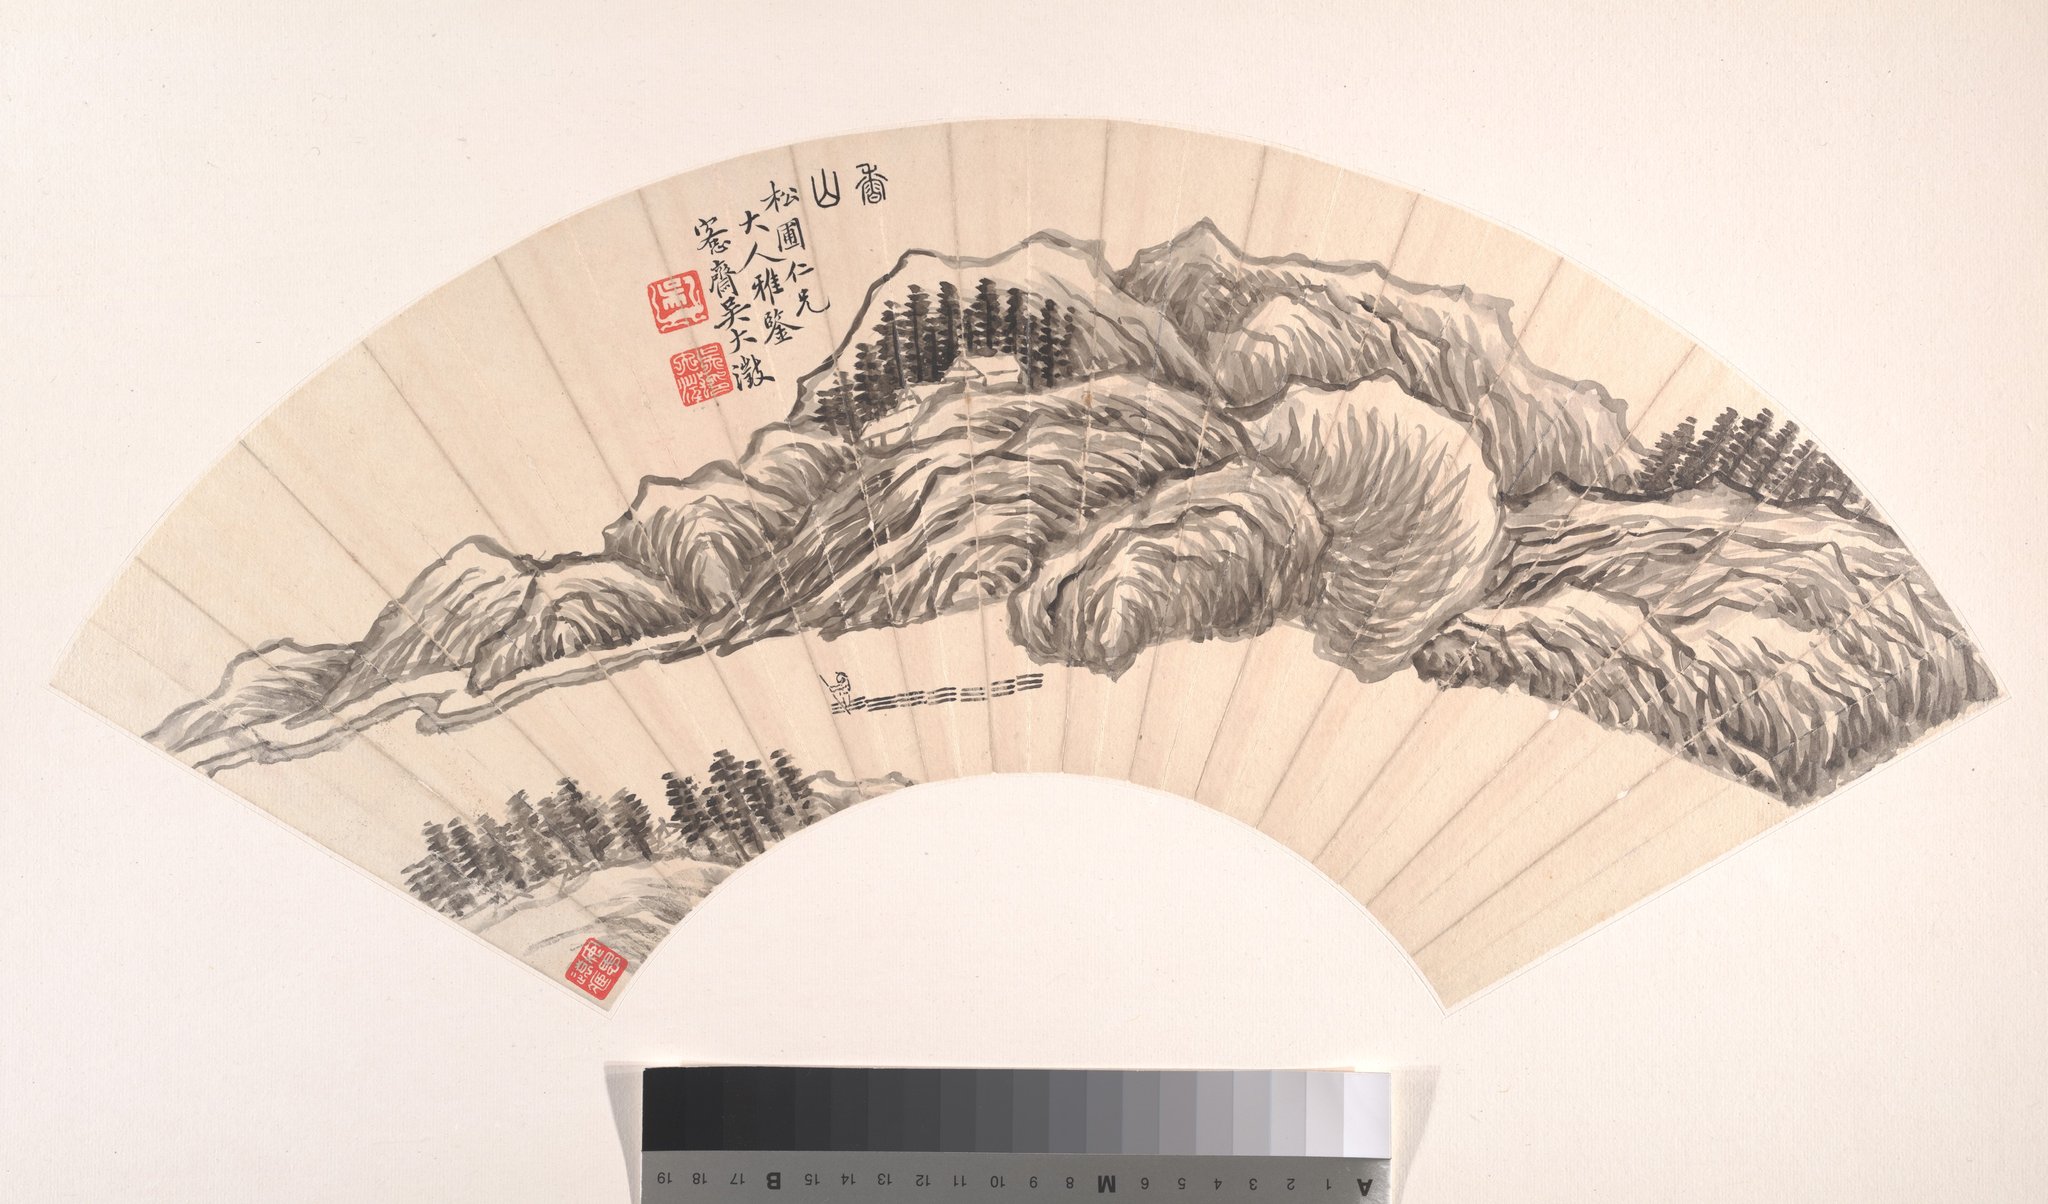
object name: folding fan mounted a an album leaf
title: Fragrant Mountains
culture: chinese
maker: wu dacheng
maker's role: artist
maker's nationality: chinese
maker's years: 1835-1902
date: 1835-1902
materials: ink, paper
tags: mountains,landscapes